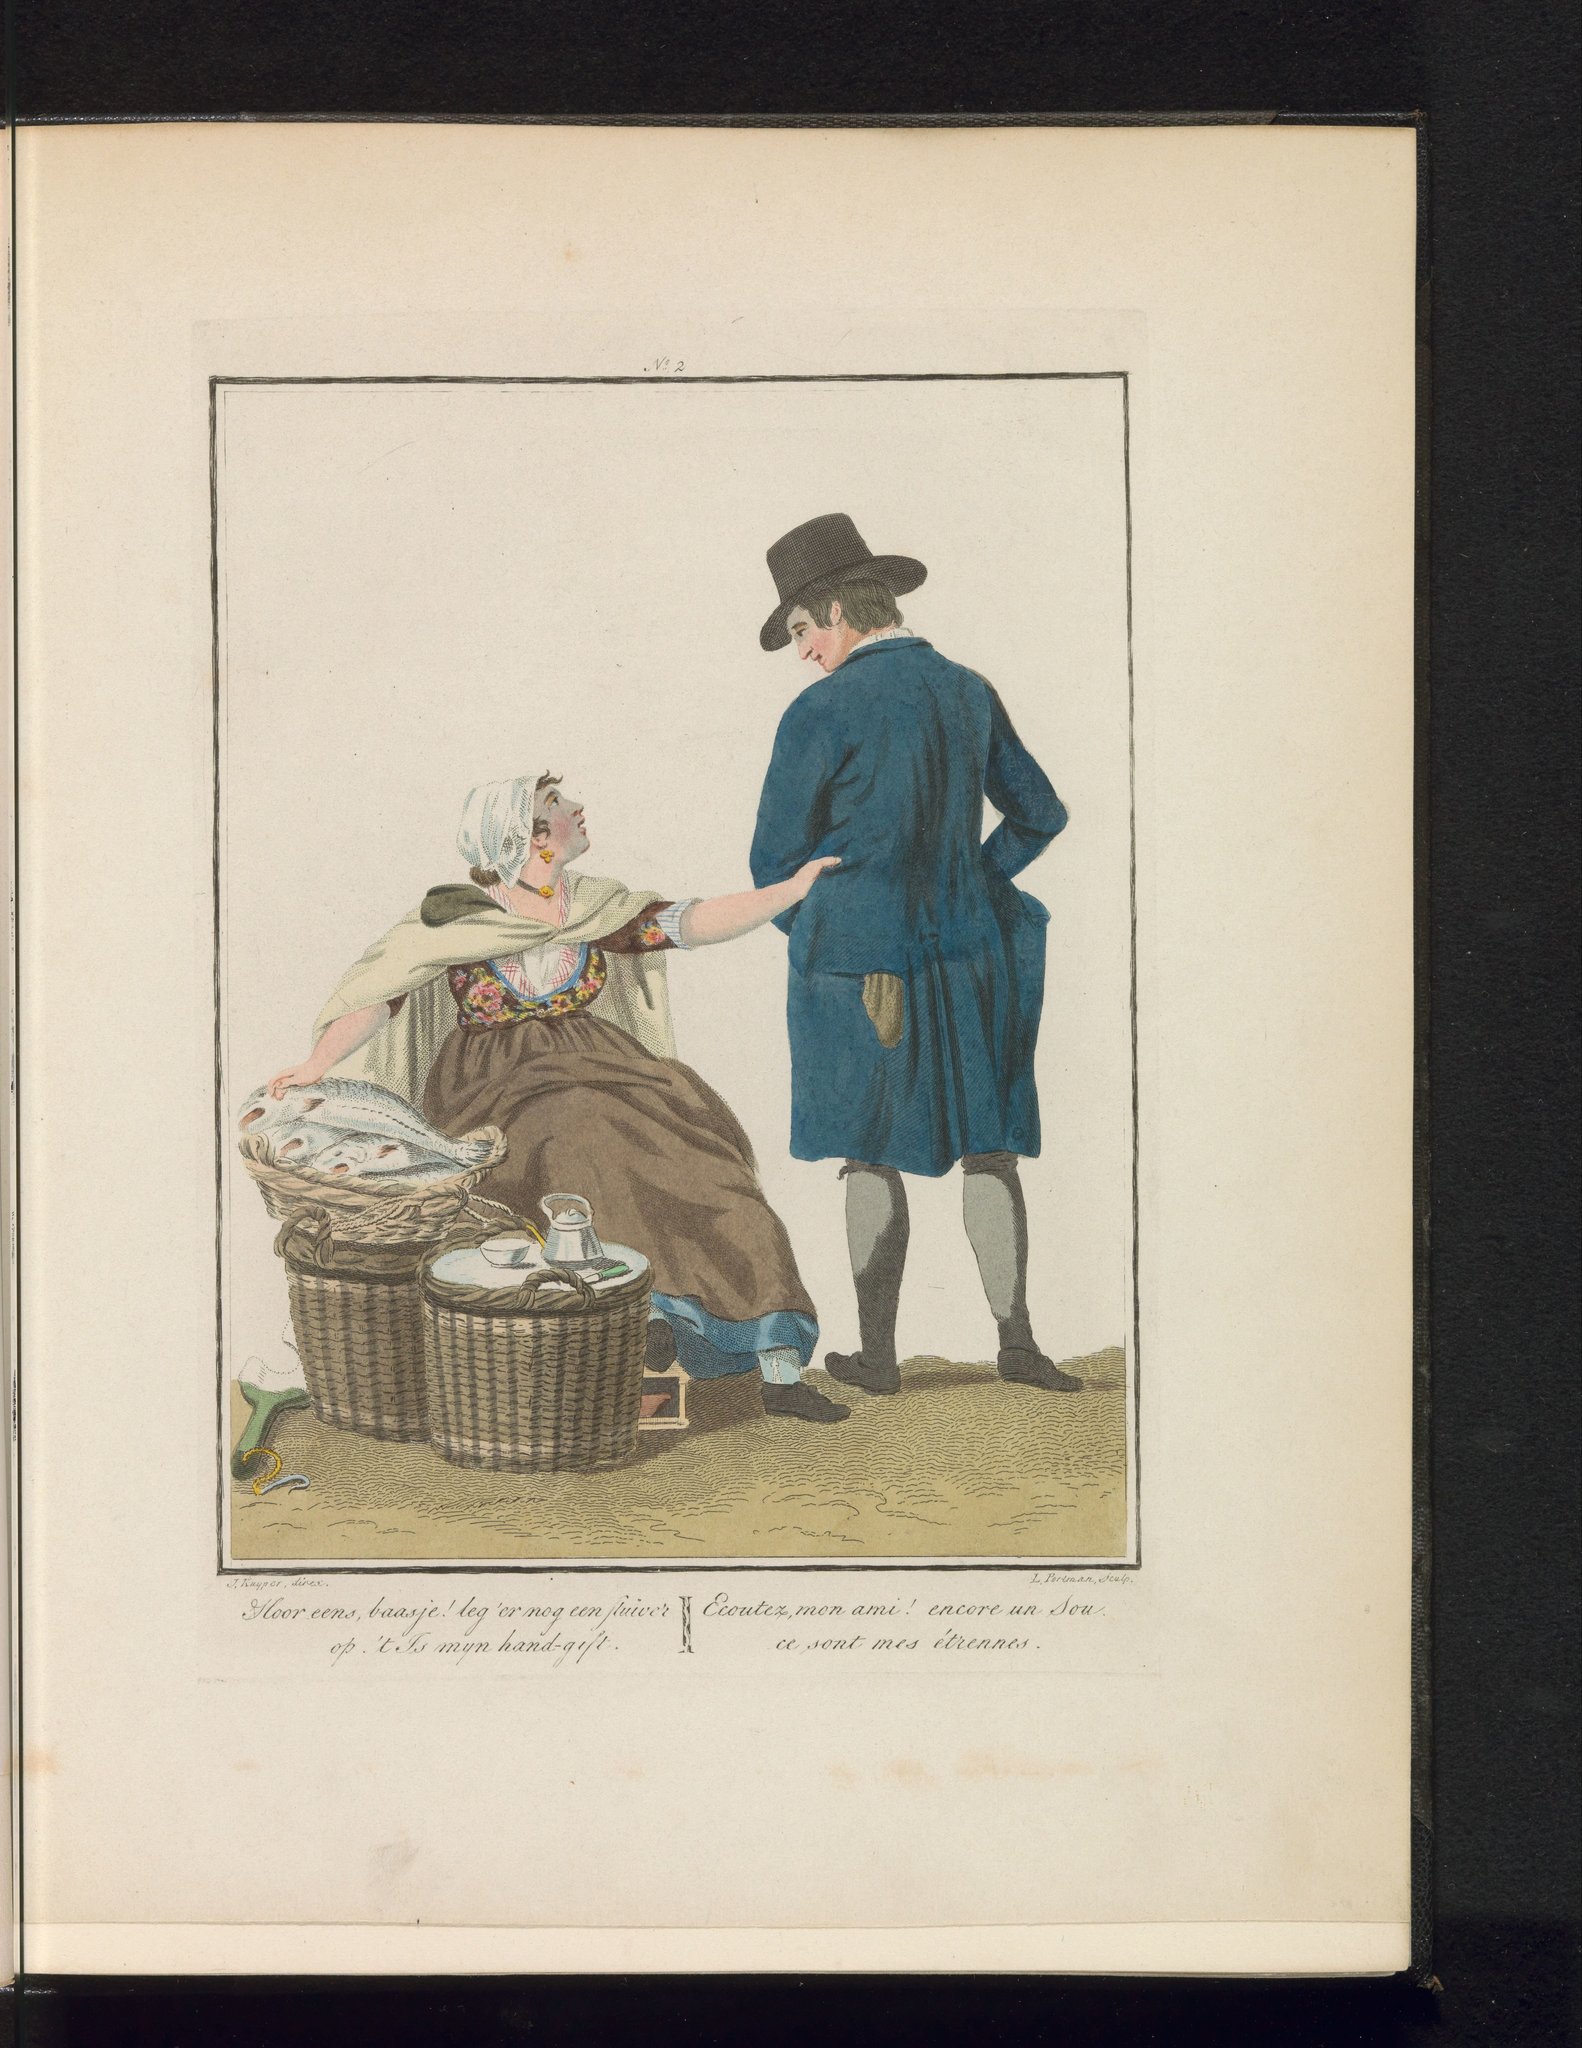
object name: book illustration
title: Visverkoopster en klant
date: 1803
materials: paper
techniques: etching, hand coloring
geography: amsterdam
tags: street-trader - bb - women engaged in trade and commerce, fishes, folk costume, regional costume, clothes, costume, amsterdam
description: Gebruikt als illustratie in: Evert Maaskamp, Afbeeldingen van de kleedingen, zeden en gewoonten in de noordelijke provincien van het Koningrijk der Nederlanden, met den aanvang der negentiende eeuw = Tableaux des habillemens, mœurs et coutumes dans les provinces septentrionales du Royaume des Pays-Bas, au commencement du dix-neuvième siècle. Amsterdam: Evert Maaskamp, 1829 [heruitgave van de oorspronkelijke platen eerst verschenen in 1803-1807].